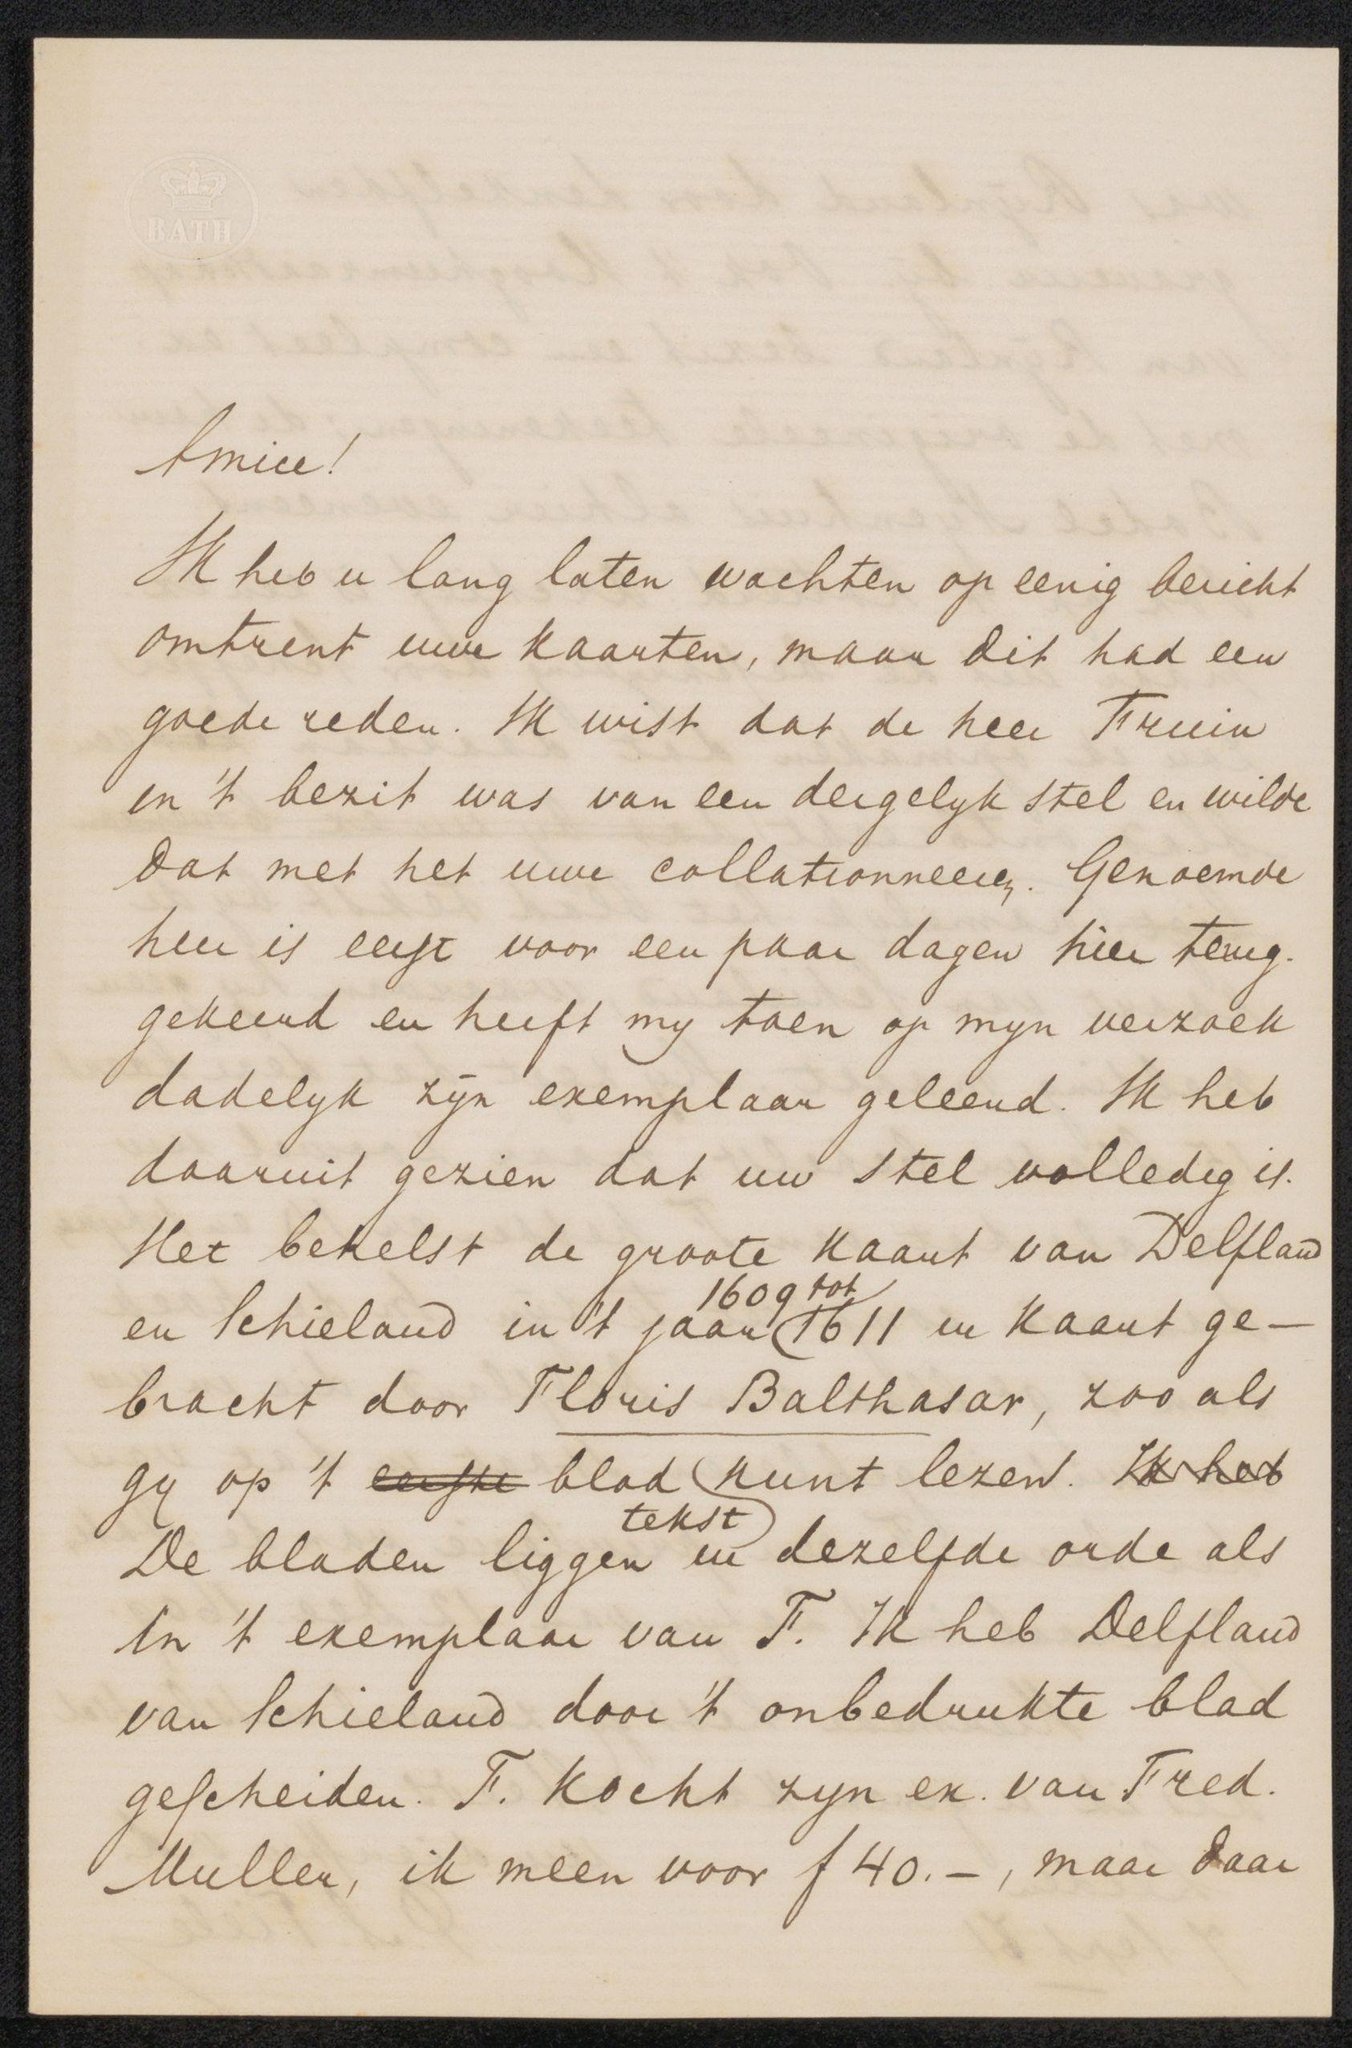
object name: letter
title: Brief aan Ary Johannes Lamme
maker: cornelis petrus tiele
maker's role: theoloog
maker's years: 1830-1902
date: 1871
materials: ink, paper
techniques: pen, writing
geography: leiden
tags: delft, print maker, floris balthasarsz. van berckenrode, draughtsman, ary johannes lamme, amsterdam, leiden, publisher, johannes tiberius bodel nijenhuis, art trade, art shop, the graphic arts, art collecting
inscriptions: collector's mark: Lugt 2228